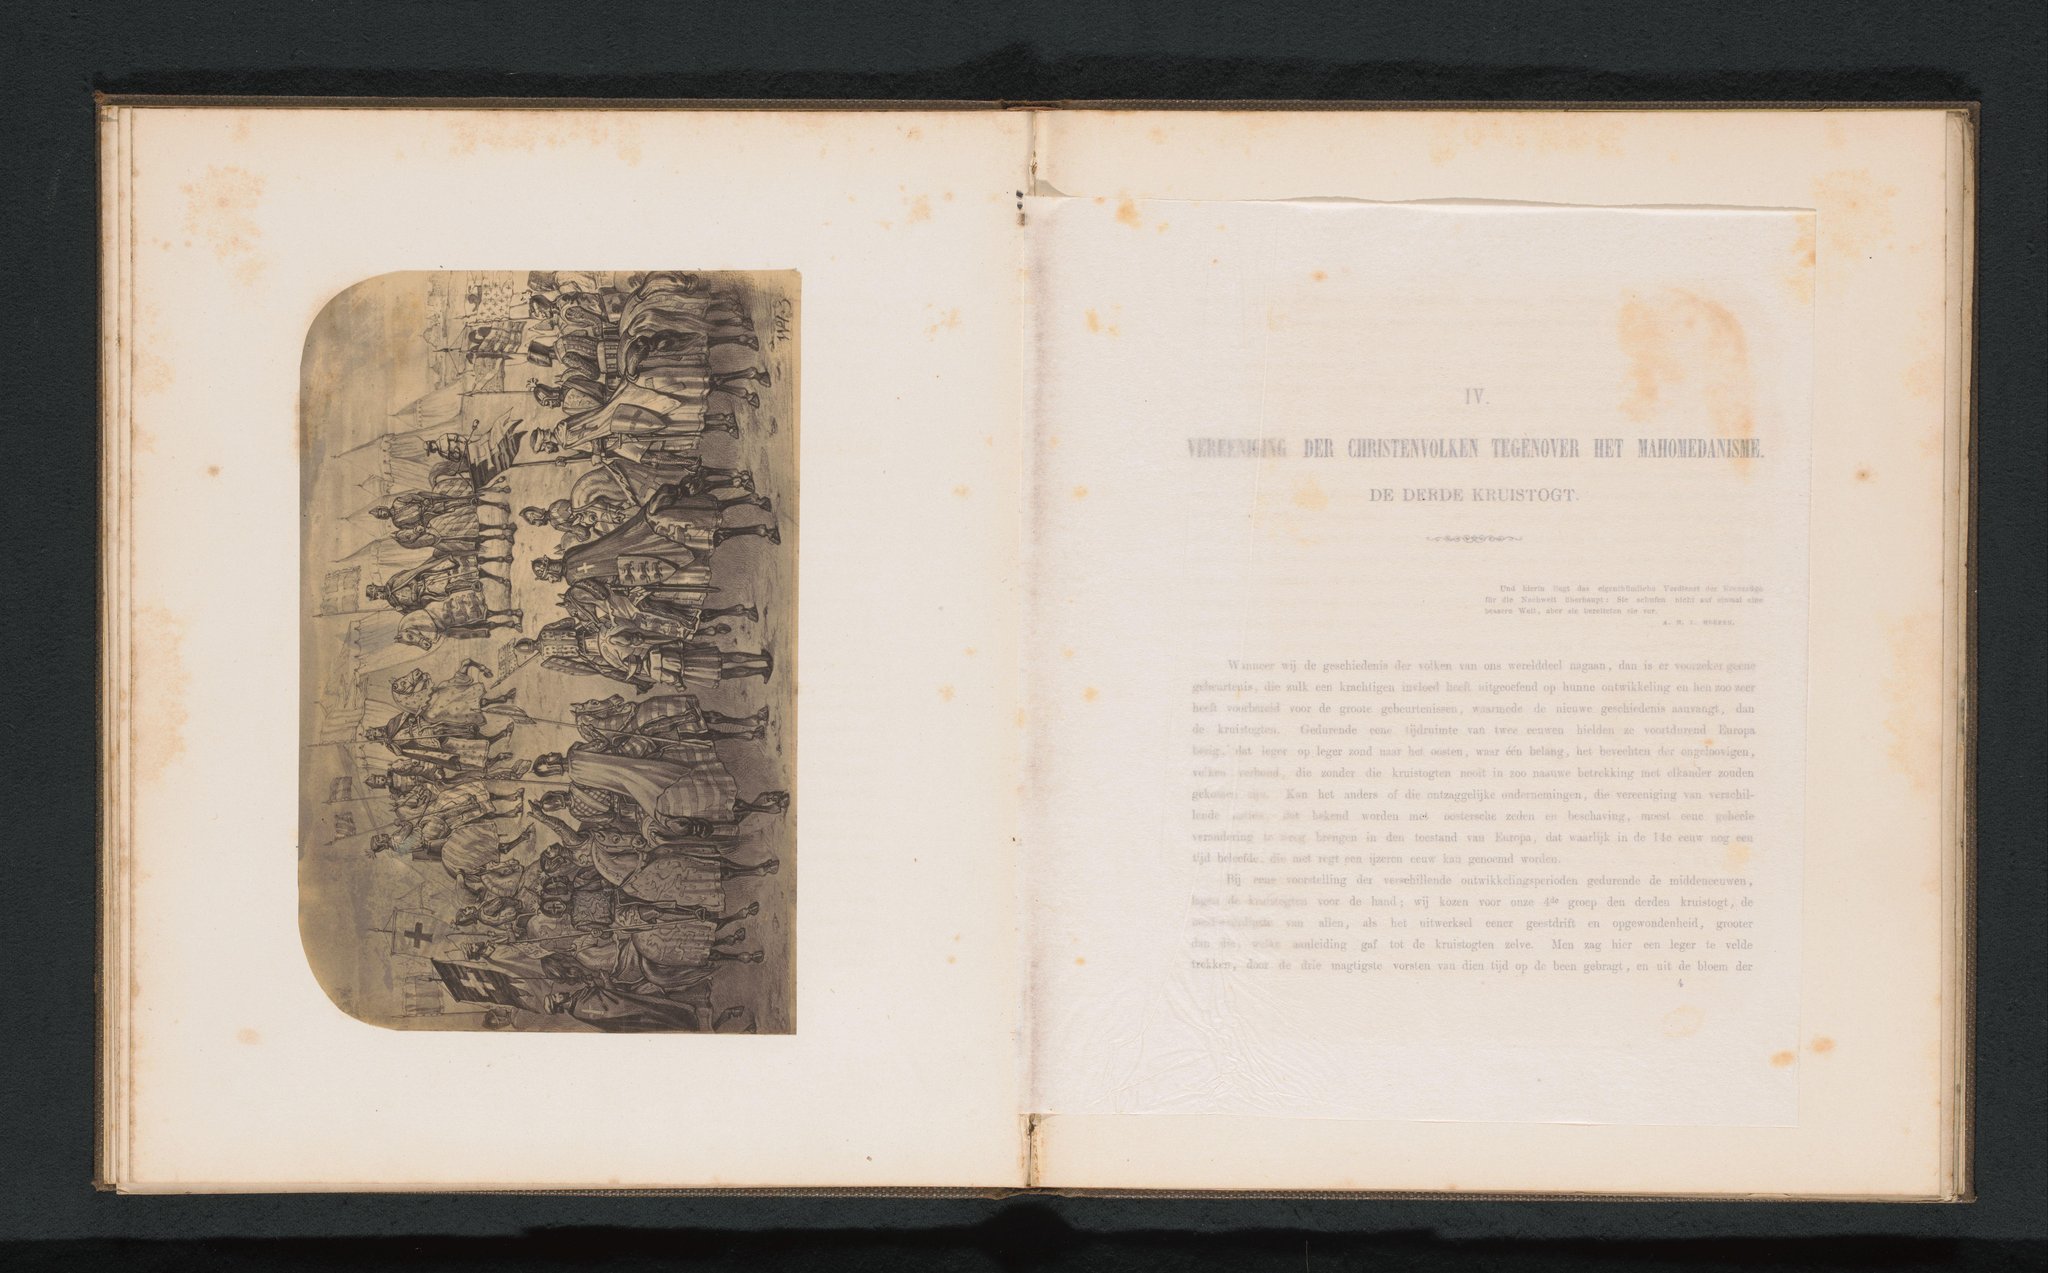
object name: page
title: Fotoreproductie van een prent van de Derde Kruistocht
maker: Anonymous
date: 1856-1861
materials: photographic support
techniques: albumen print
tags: militant proselytizing: religious war, crusade, etc.